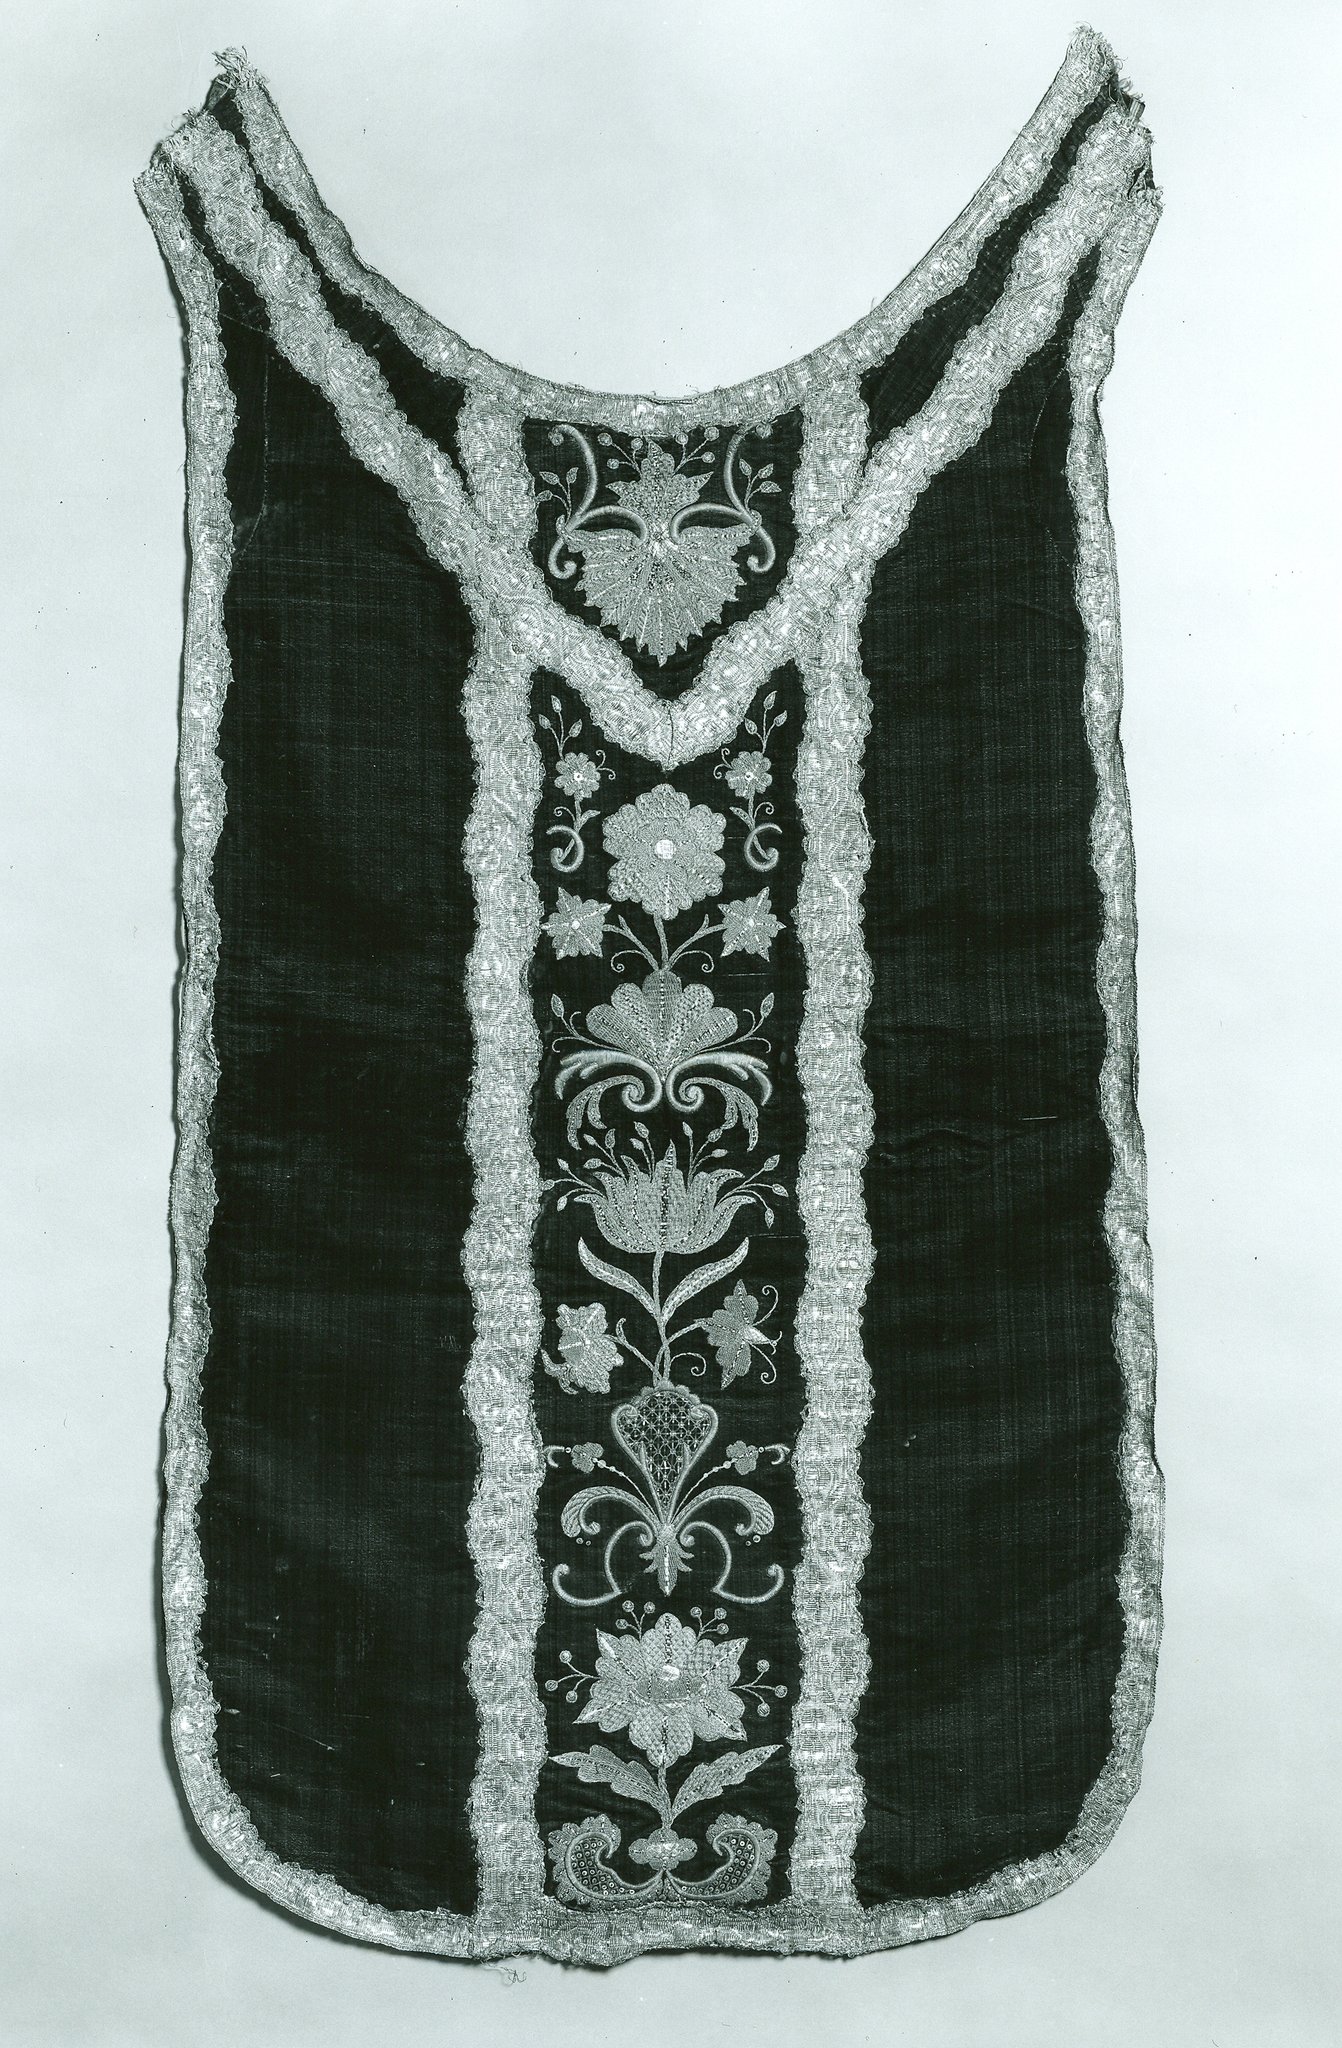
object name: chasuble back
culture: italian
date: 1701-1800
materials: linen, metal, paper, silk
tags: flowers